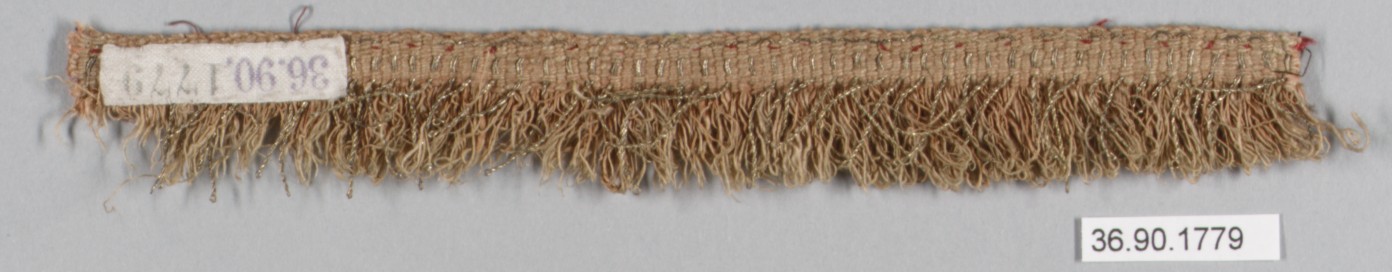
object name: fringe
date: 1767-1800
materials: metal thread